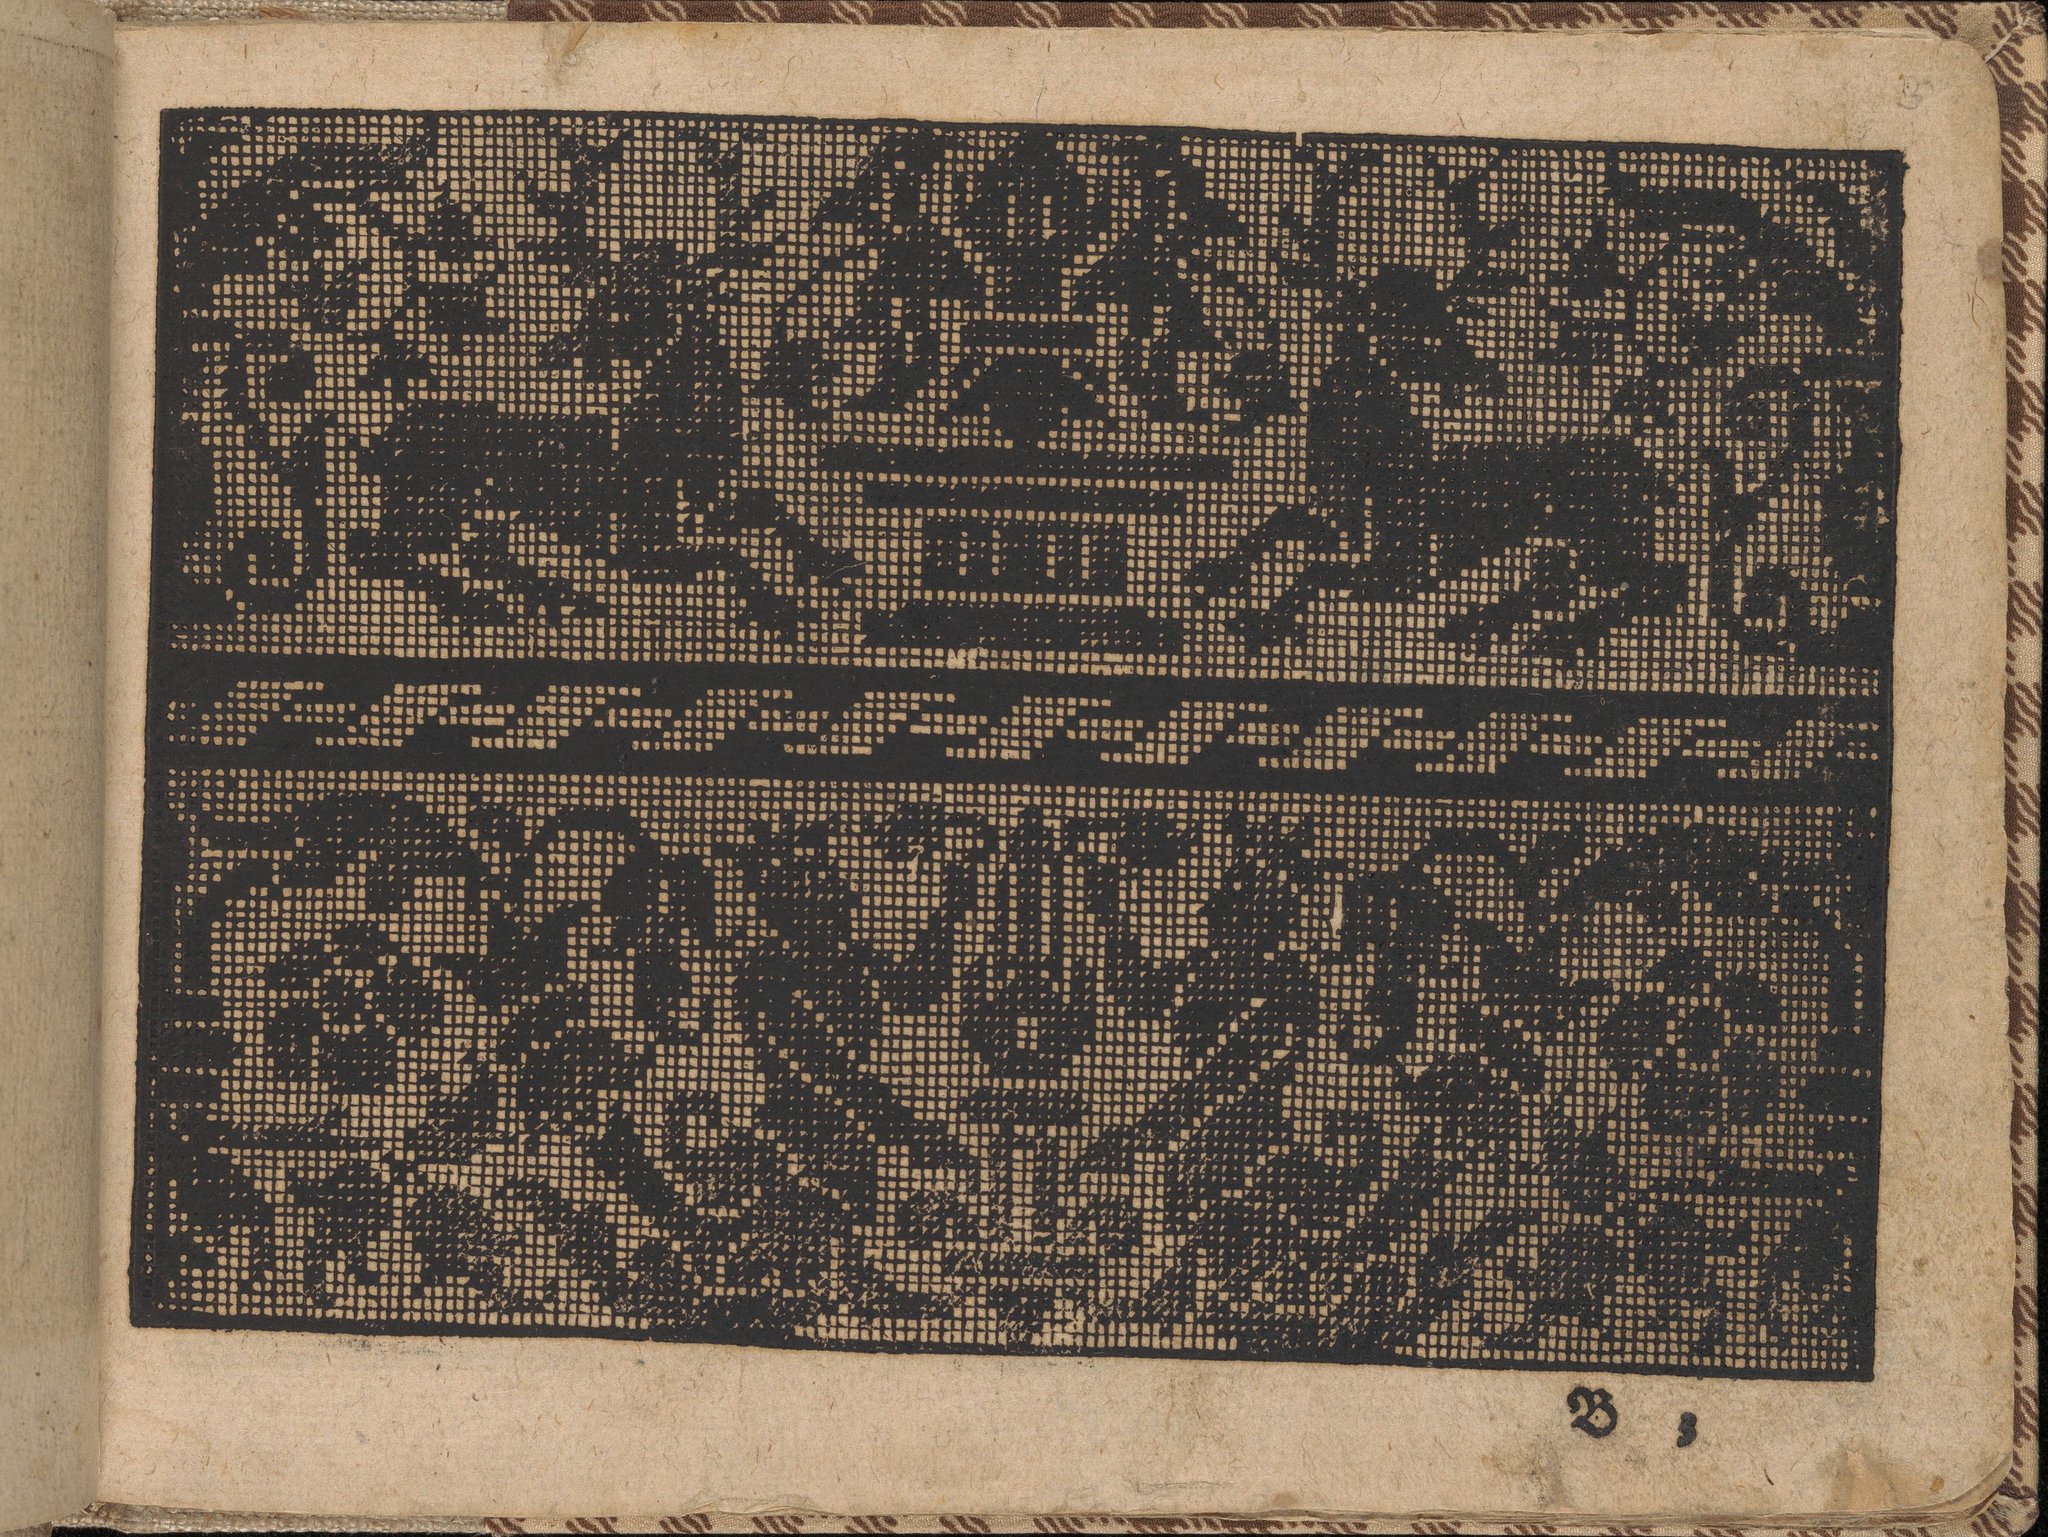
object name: book print ornament architecture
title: New Künstlichs Modelbuch (Page 5 recto)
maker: bernhard jobin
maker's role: publisher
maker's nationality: swiss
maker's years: 1535-1597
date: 1600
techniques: woodcut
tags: animals,flowers